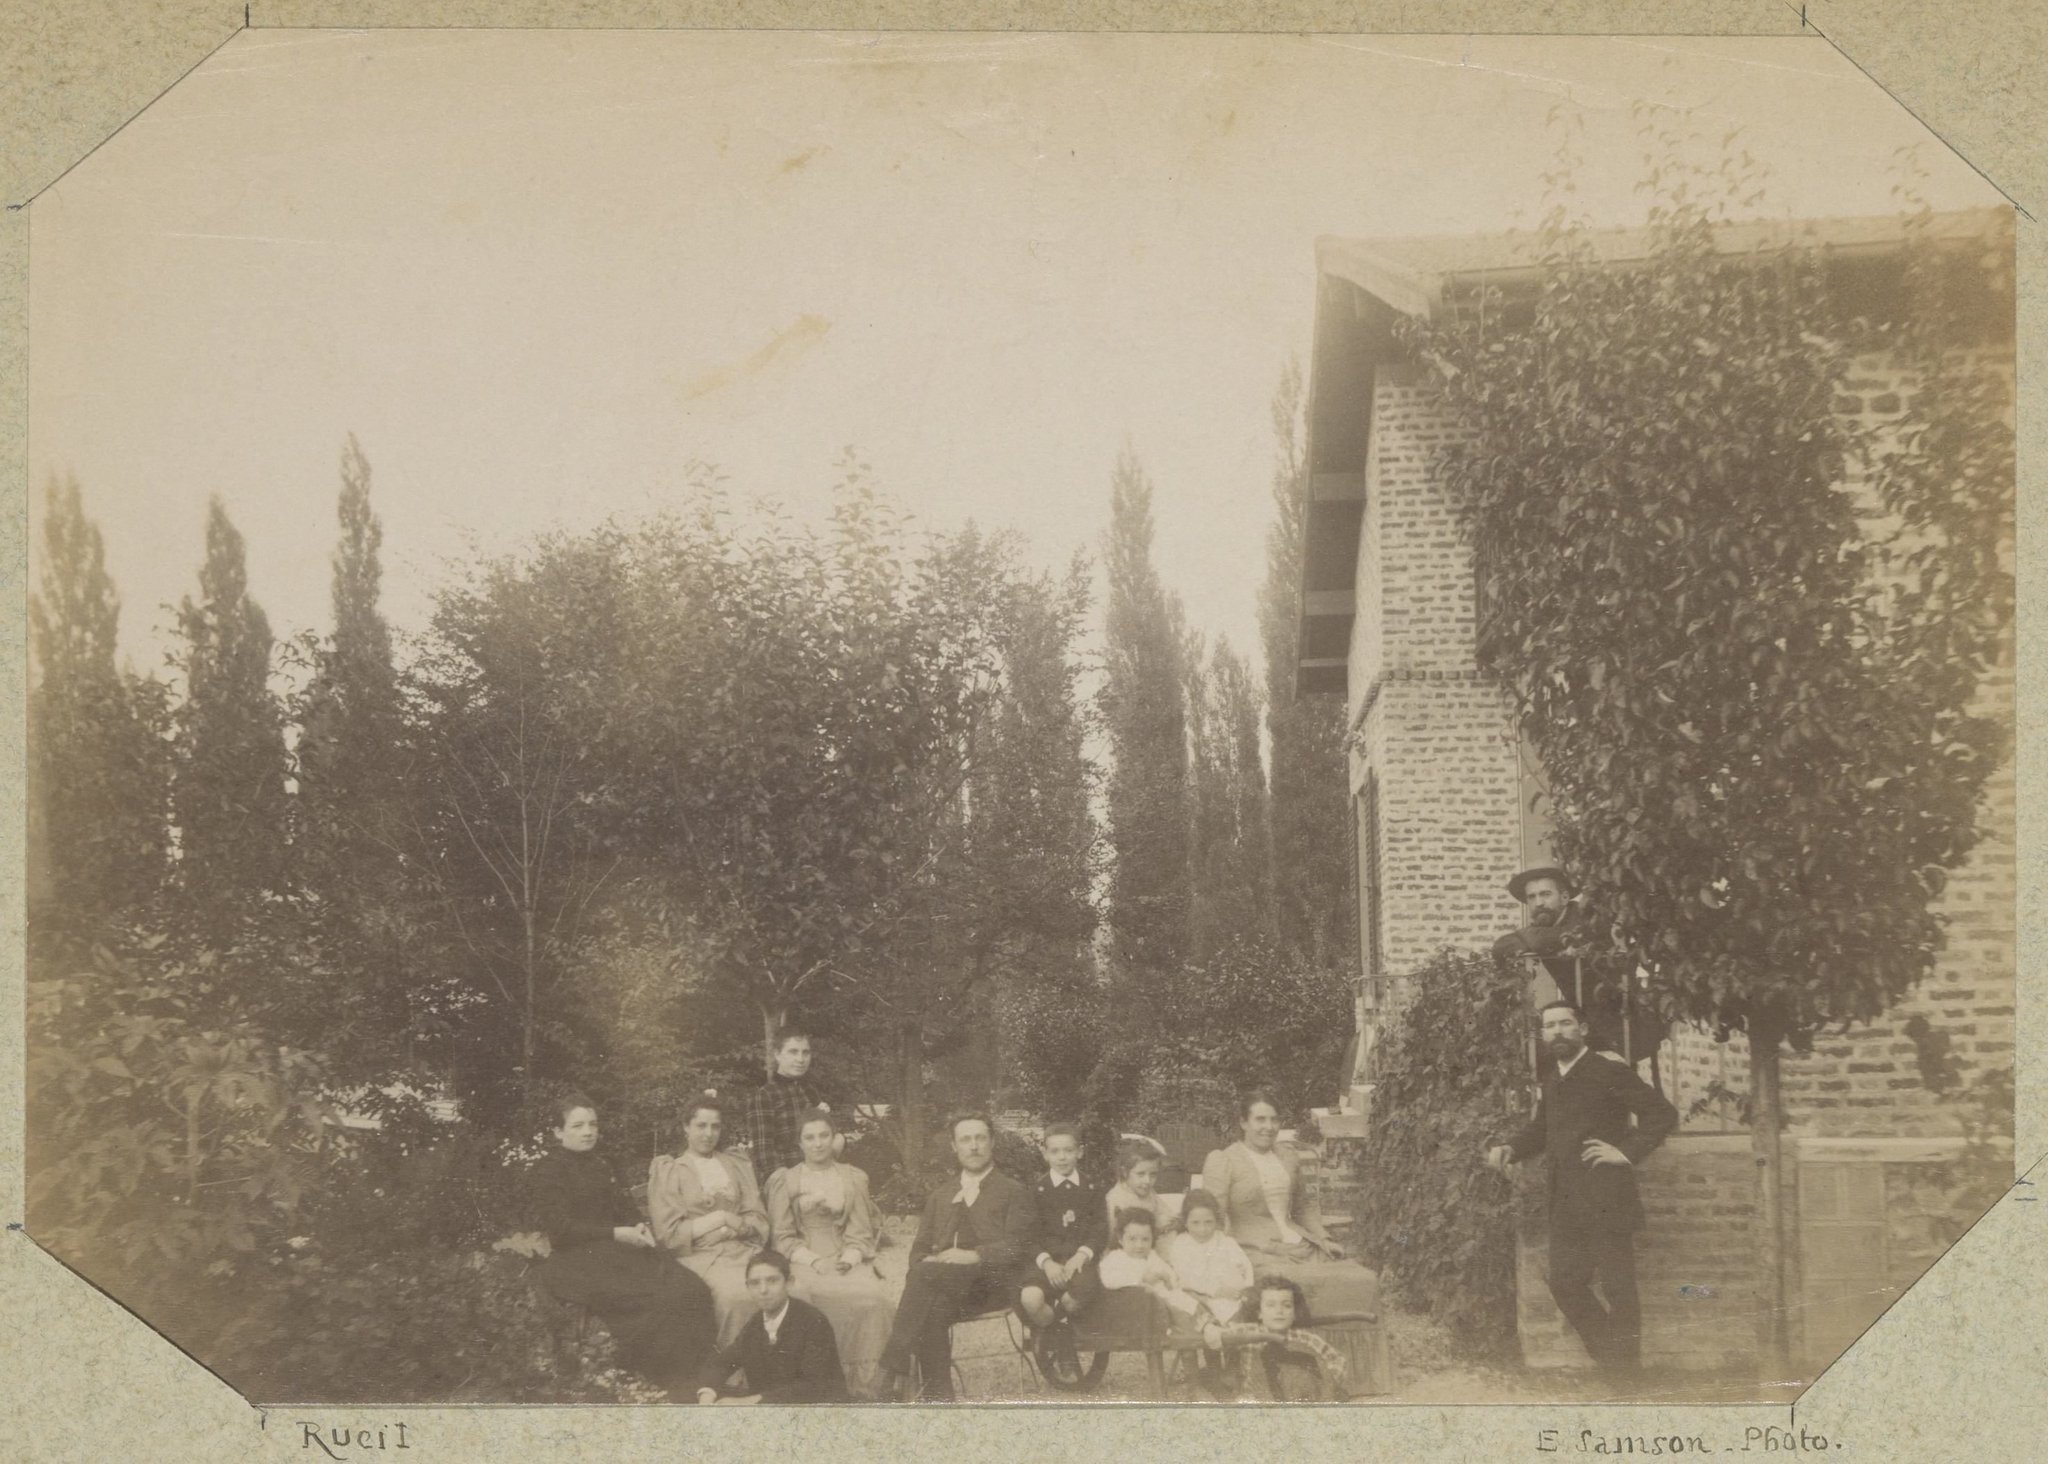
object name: photograph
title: Groepsportret van een Franse familie in een tuin in Rueil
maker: e. samson (fotograaf)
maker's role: fotograaf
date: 1890-1900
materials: paper, photographic support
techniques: albumen print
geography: rueil-malmaison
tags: garden, family life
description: Onderdeel van Album van een Franse amateur met foto's van Frankrijk, Algerije, Palmyra, de Wereldtentoonstelling van 1900 en van bekende Fransen.